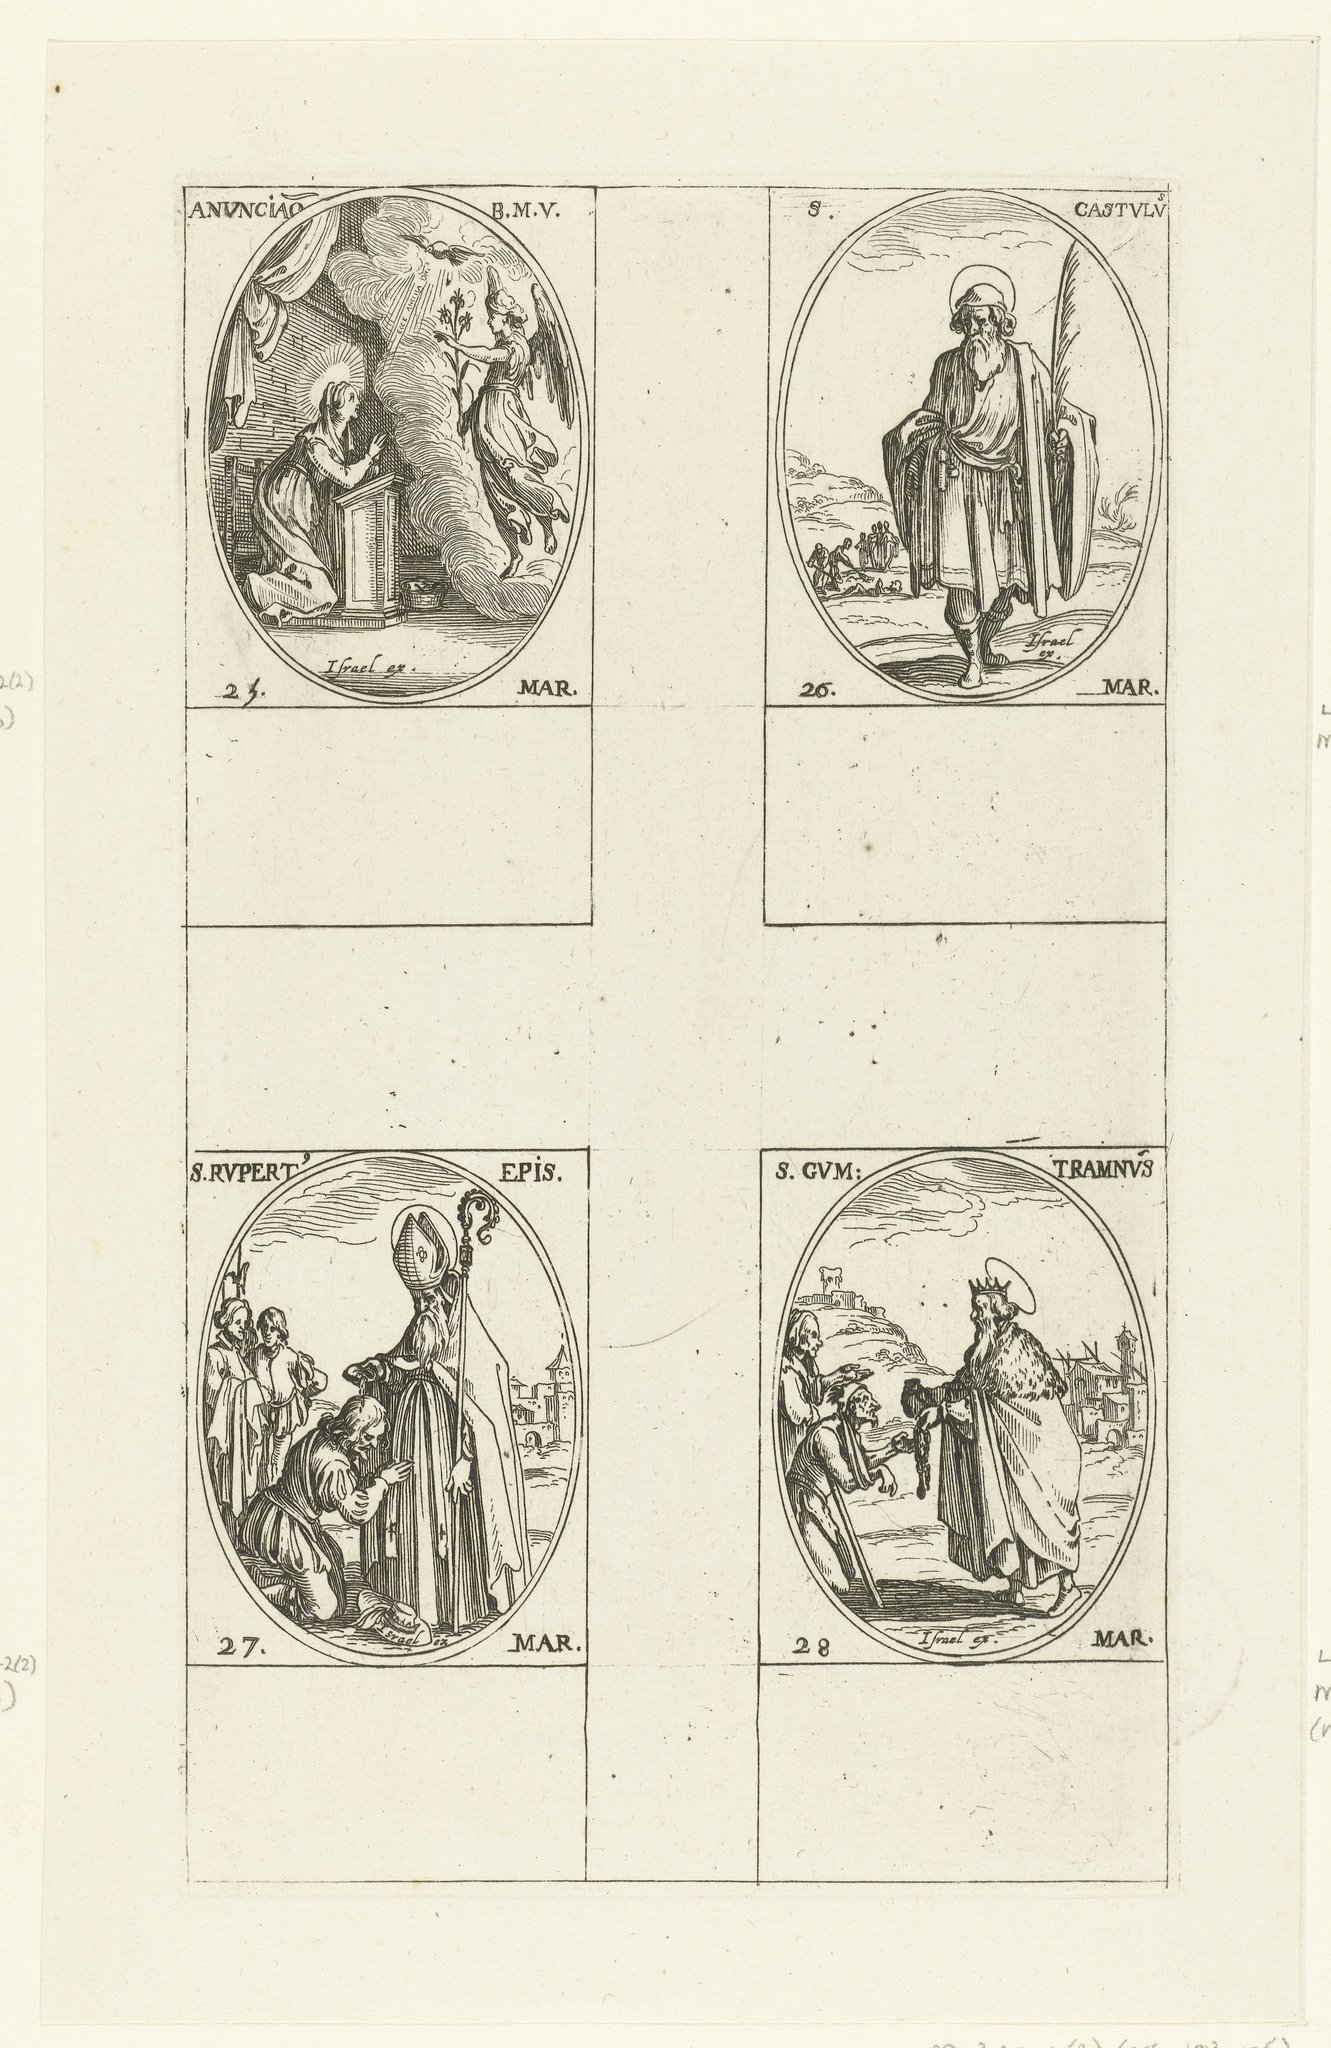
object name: print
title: Annunciatie (Maria-Boodschap), Heilige Castulus van Rome, Heilige Rupertus van Salzburg, Heilige Guntramus van Bourgondië (25-28 maart)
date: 1632-1636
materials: paper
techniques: etching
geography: nancy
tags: the annunciation: mary kneeling, male saints (with name)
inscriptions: collector's mark: Lugt 240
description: Blad met vier ovale voorstellingen, elk met opschrift en datum in het Latijn: linksboven de aankondiging van de geboorte van Christus aan Maria, rechtsboven de Heilige Castulus met een palmtak, linksonder de Heilige Rupertus als bisschop die een man doopt, rechtsonder de Heilige Guntramus als koning die zijn rijkdommen aan de armen uitdeelt. Deze prent is onderdeel van een serie prenten met voorstellingen van de heiligen en de christelijke feestdagen van het jaar. Er zijn steeds vier scènes van één plaat op één blad gedrukt. Inclusief bijbehorend titelblad en frontispice gaat het in totaal om 124 platen (490 voorstellingen). De drie platen met de laatste 12 scènes (de veranderlijke christelijke feestdagen) zijn in de derde staat versneden tot 12 kleine plaatjes, en met een apart titelblad uitgegeven.